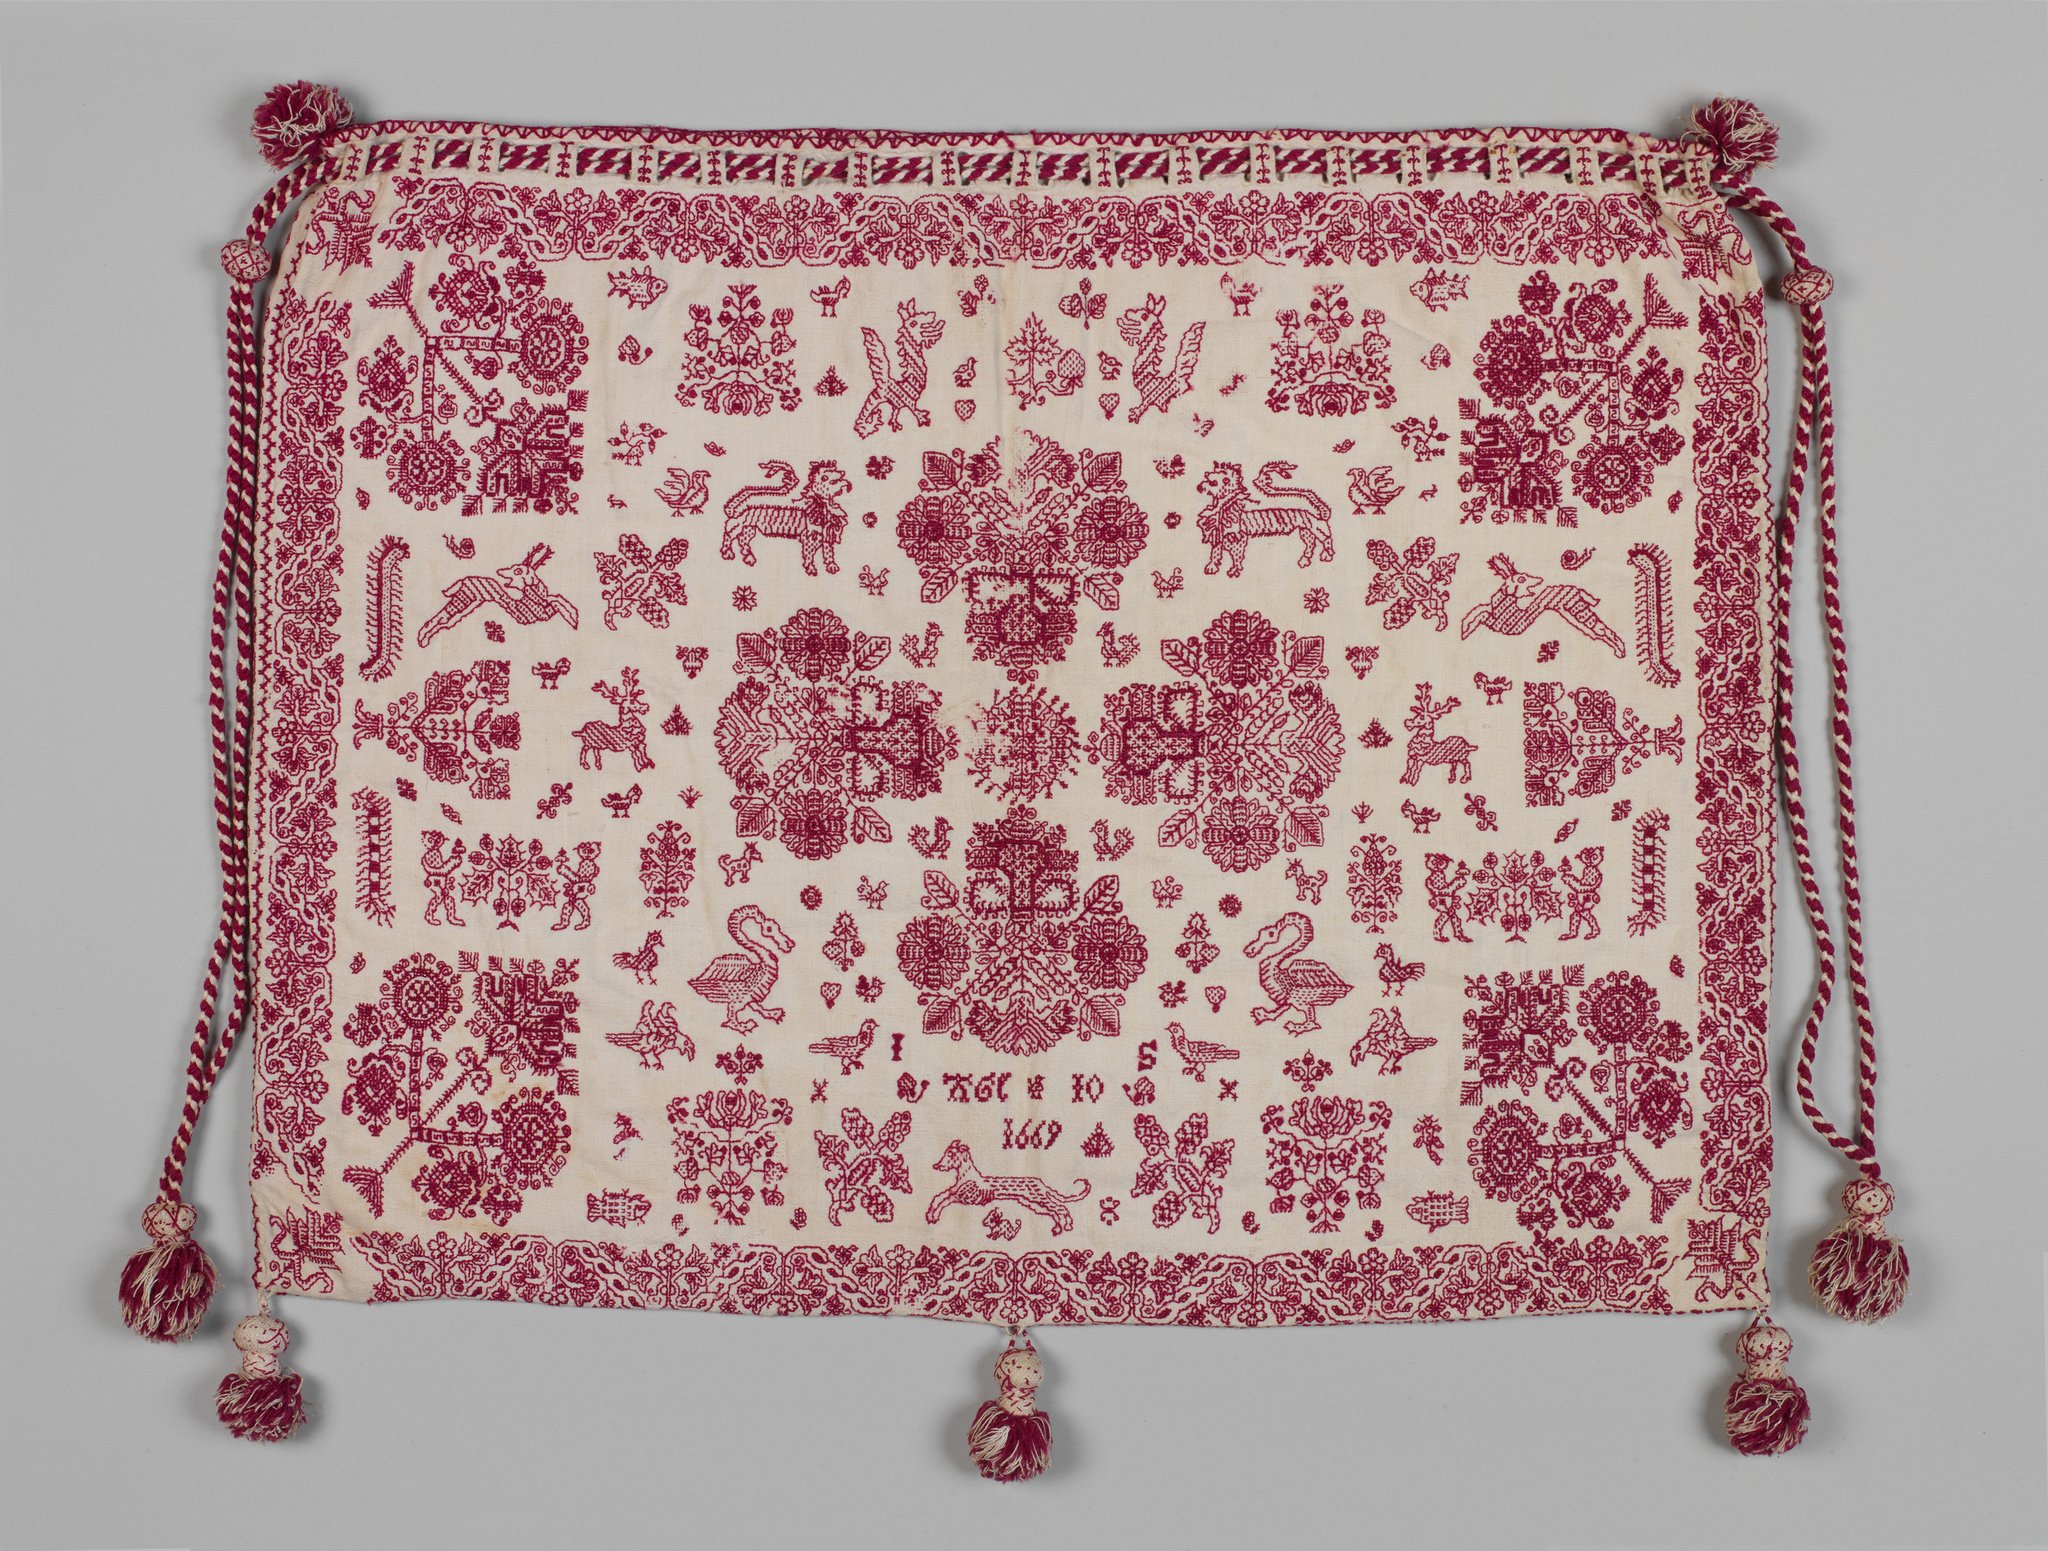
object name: work bag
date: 1669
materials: linen, thread, wool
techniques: stitching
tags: birds,deer,dogs,lions